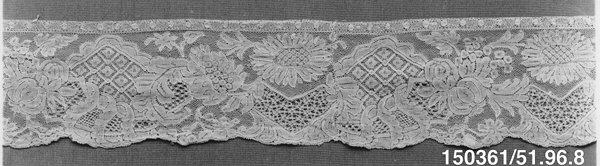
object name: border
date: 1701-1750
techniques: lace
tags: flowers